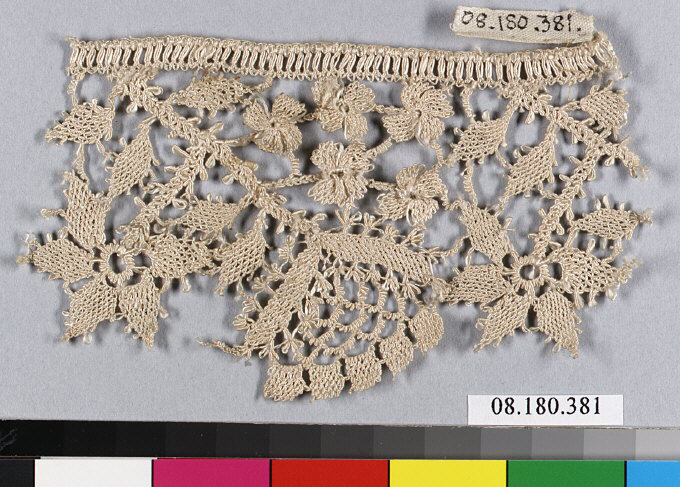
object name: fragment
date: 1801-1900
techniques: lace